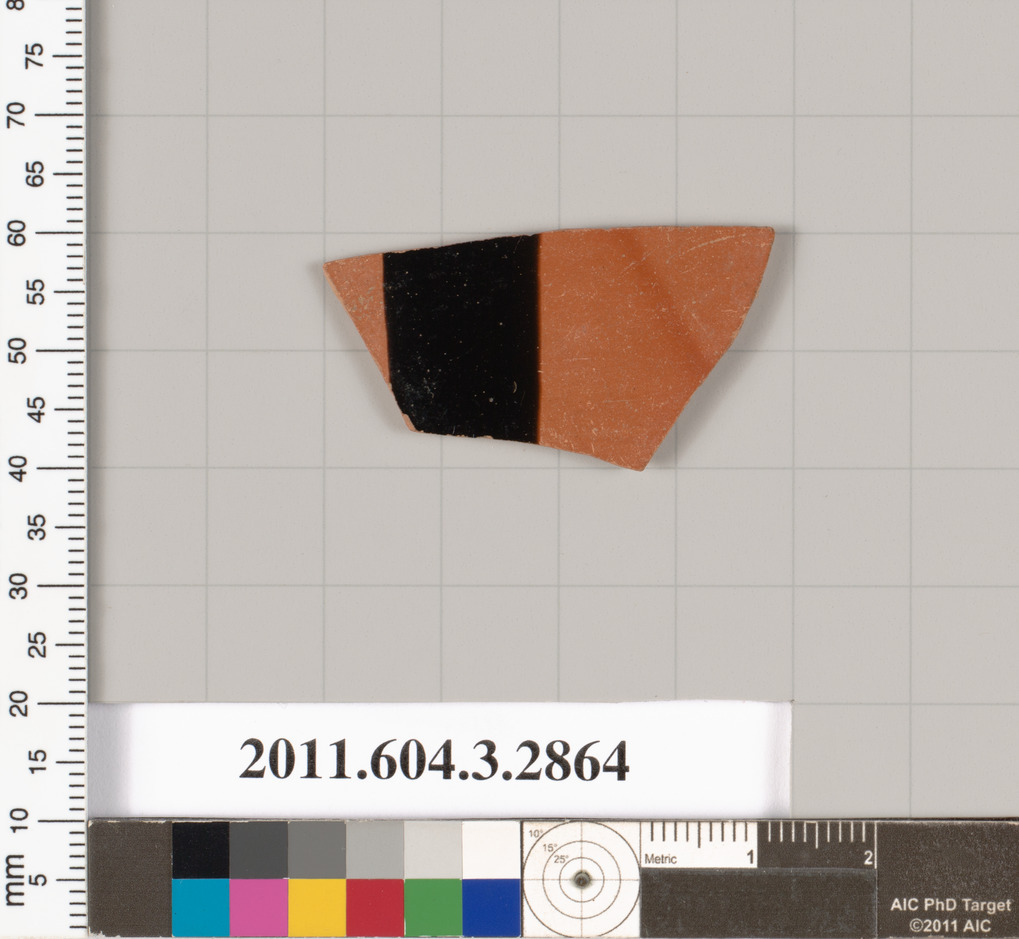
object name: undetermined shape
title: Terracotta fragment of an undetermined shape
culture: greek, attic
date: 600-401 BCE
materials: terracotta